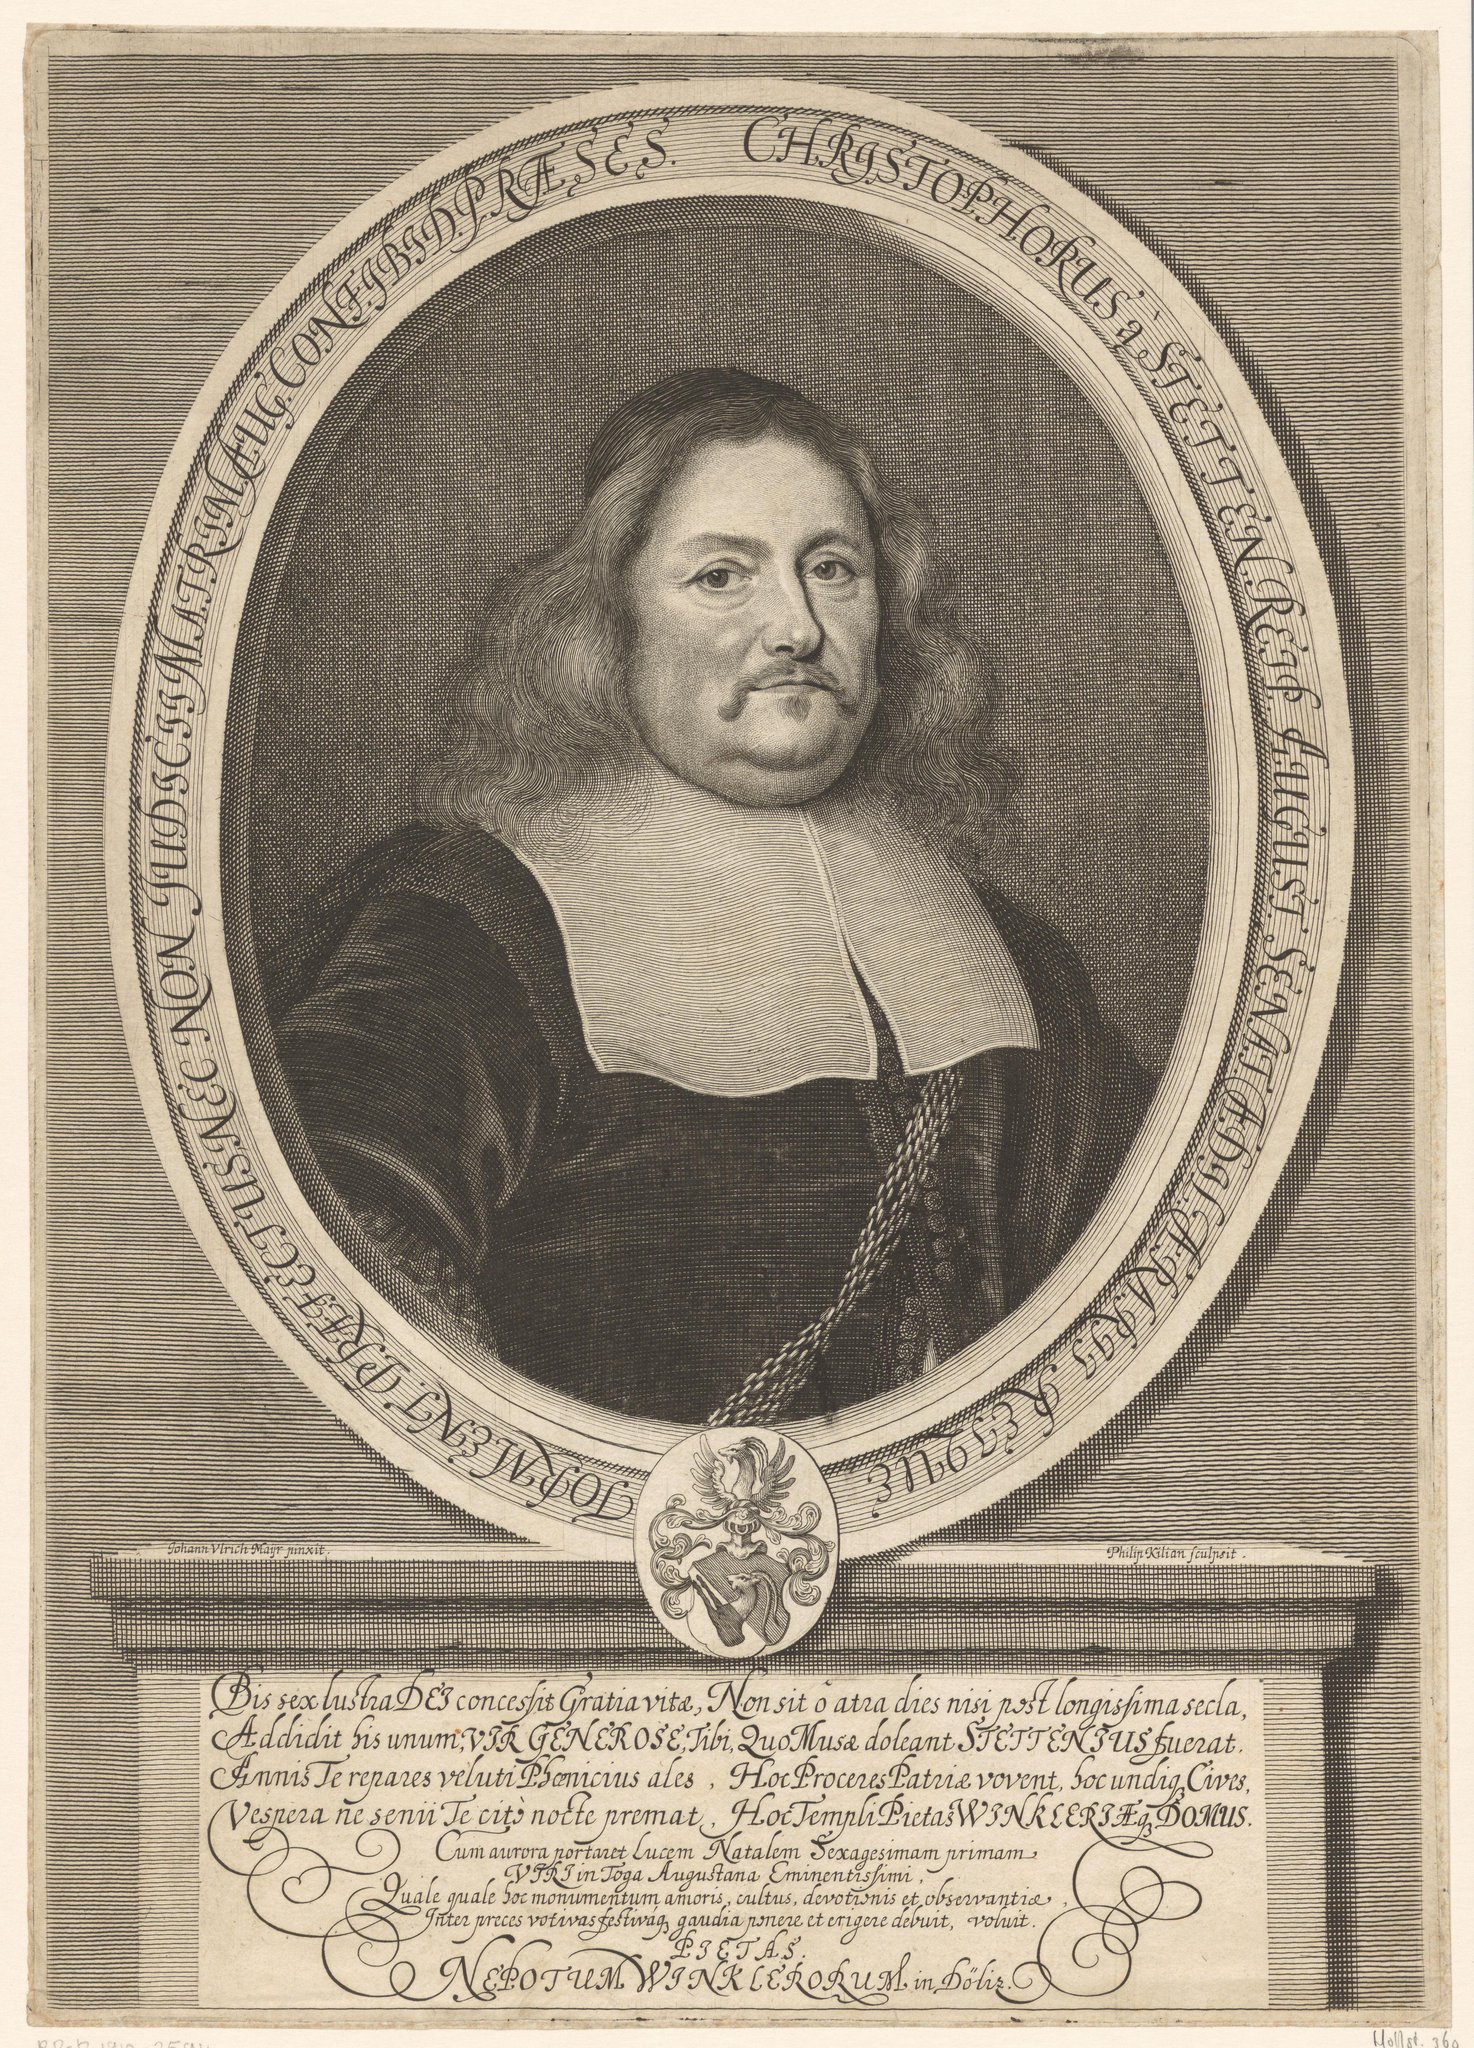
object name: print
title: Portret van Christoph von Stetten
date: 1673-1693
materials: paper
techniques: engraving, etching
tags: augsburg, historical persons, counsellor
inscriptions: collector's mark: Lugt 2228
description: Tekst in het Latijn in de omlijsting en op de sokkel.